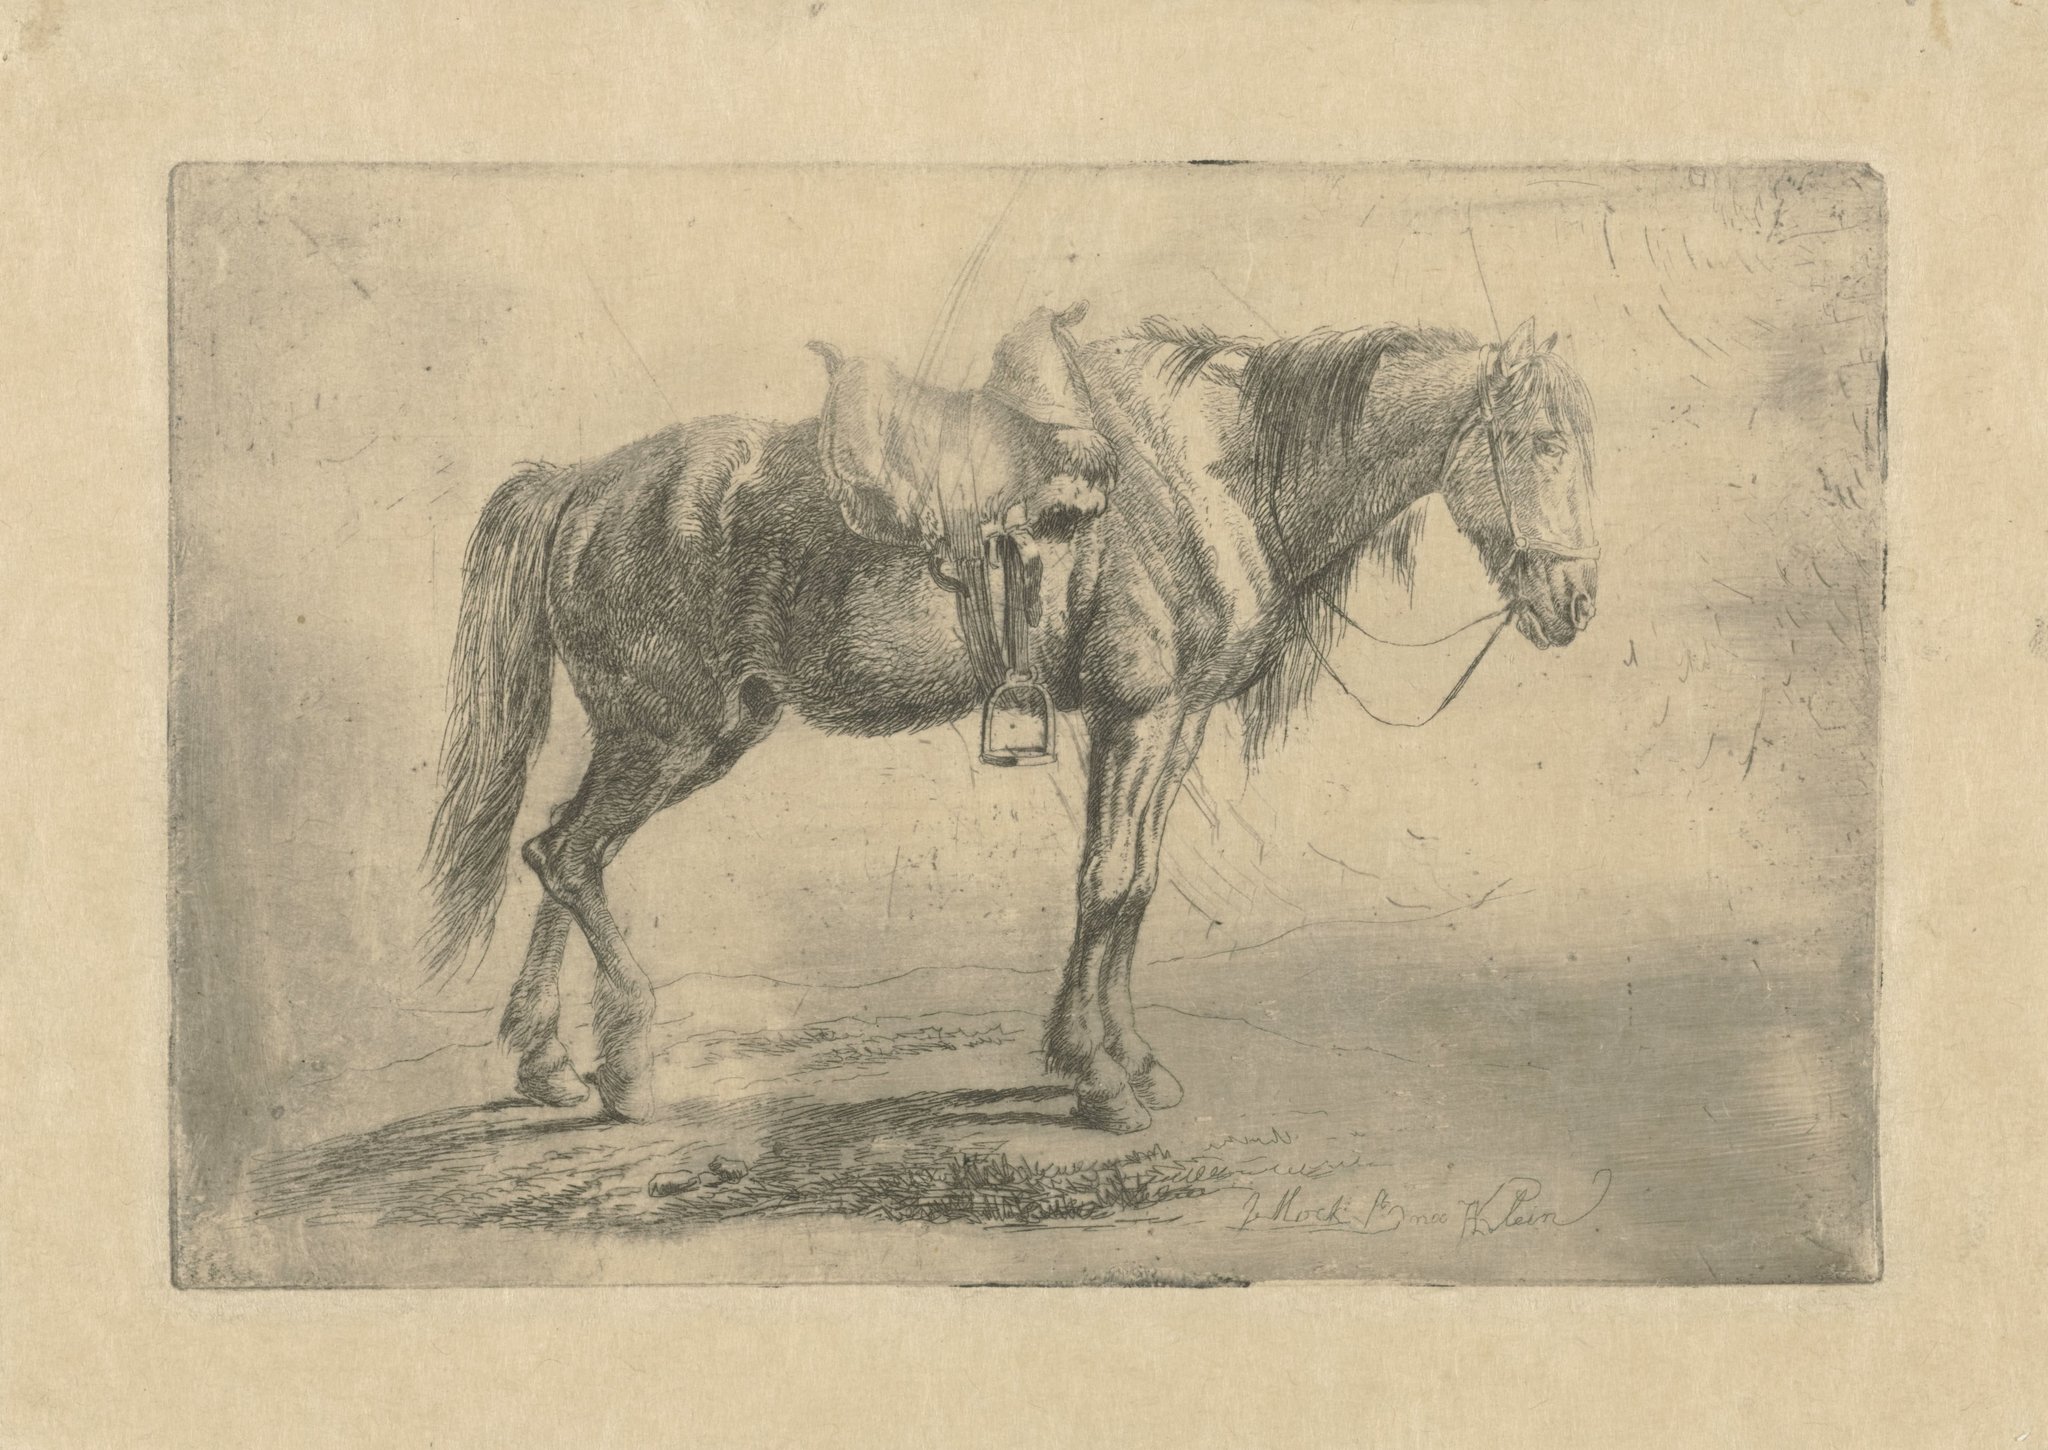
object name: print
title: Gezadeld paard naar rechts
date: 1810-1884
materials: paper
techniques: etching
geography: netherlands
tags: saddle, horse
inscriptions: collector's mark: Lugt 2228